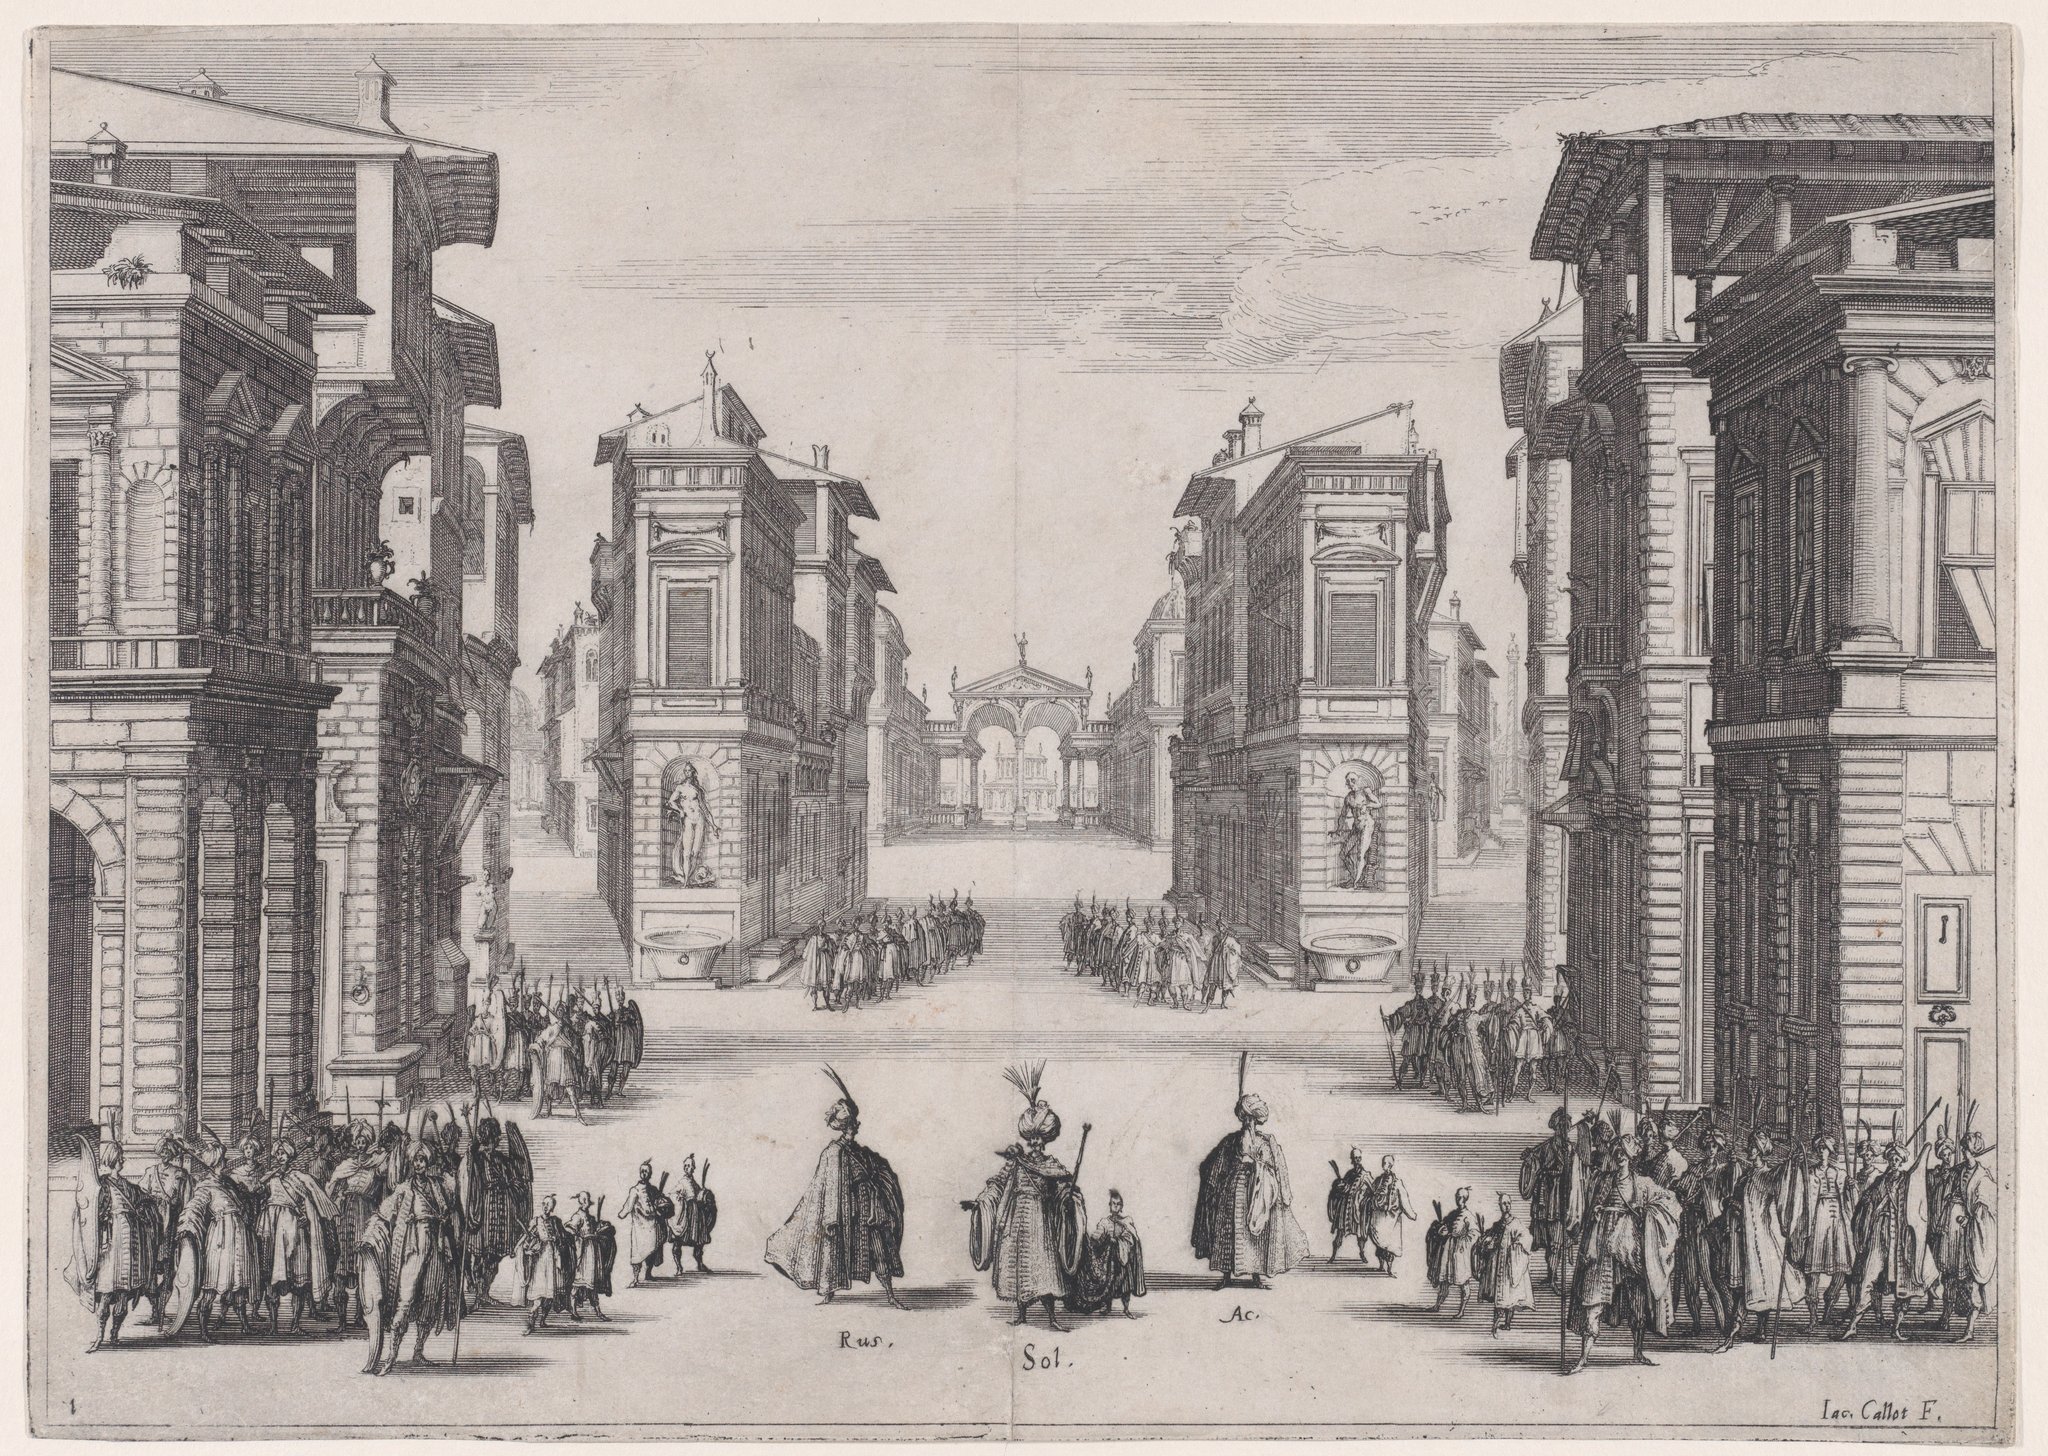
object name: print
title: Soliman, 1er Act, from "Soliman"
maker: jacques callot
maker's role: artist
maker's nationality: french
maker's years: 1592-1635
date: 1620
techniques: etching